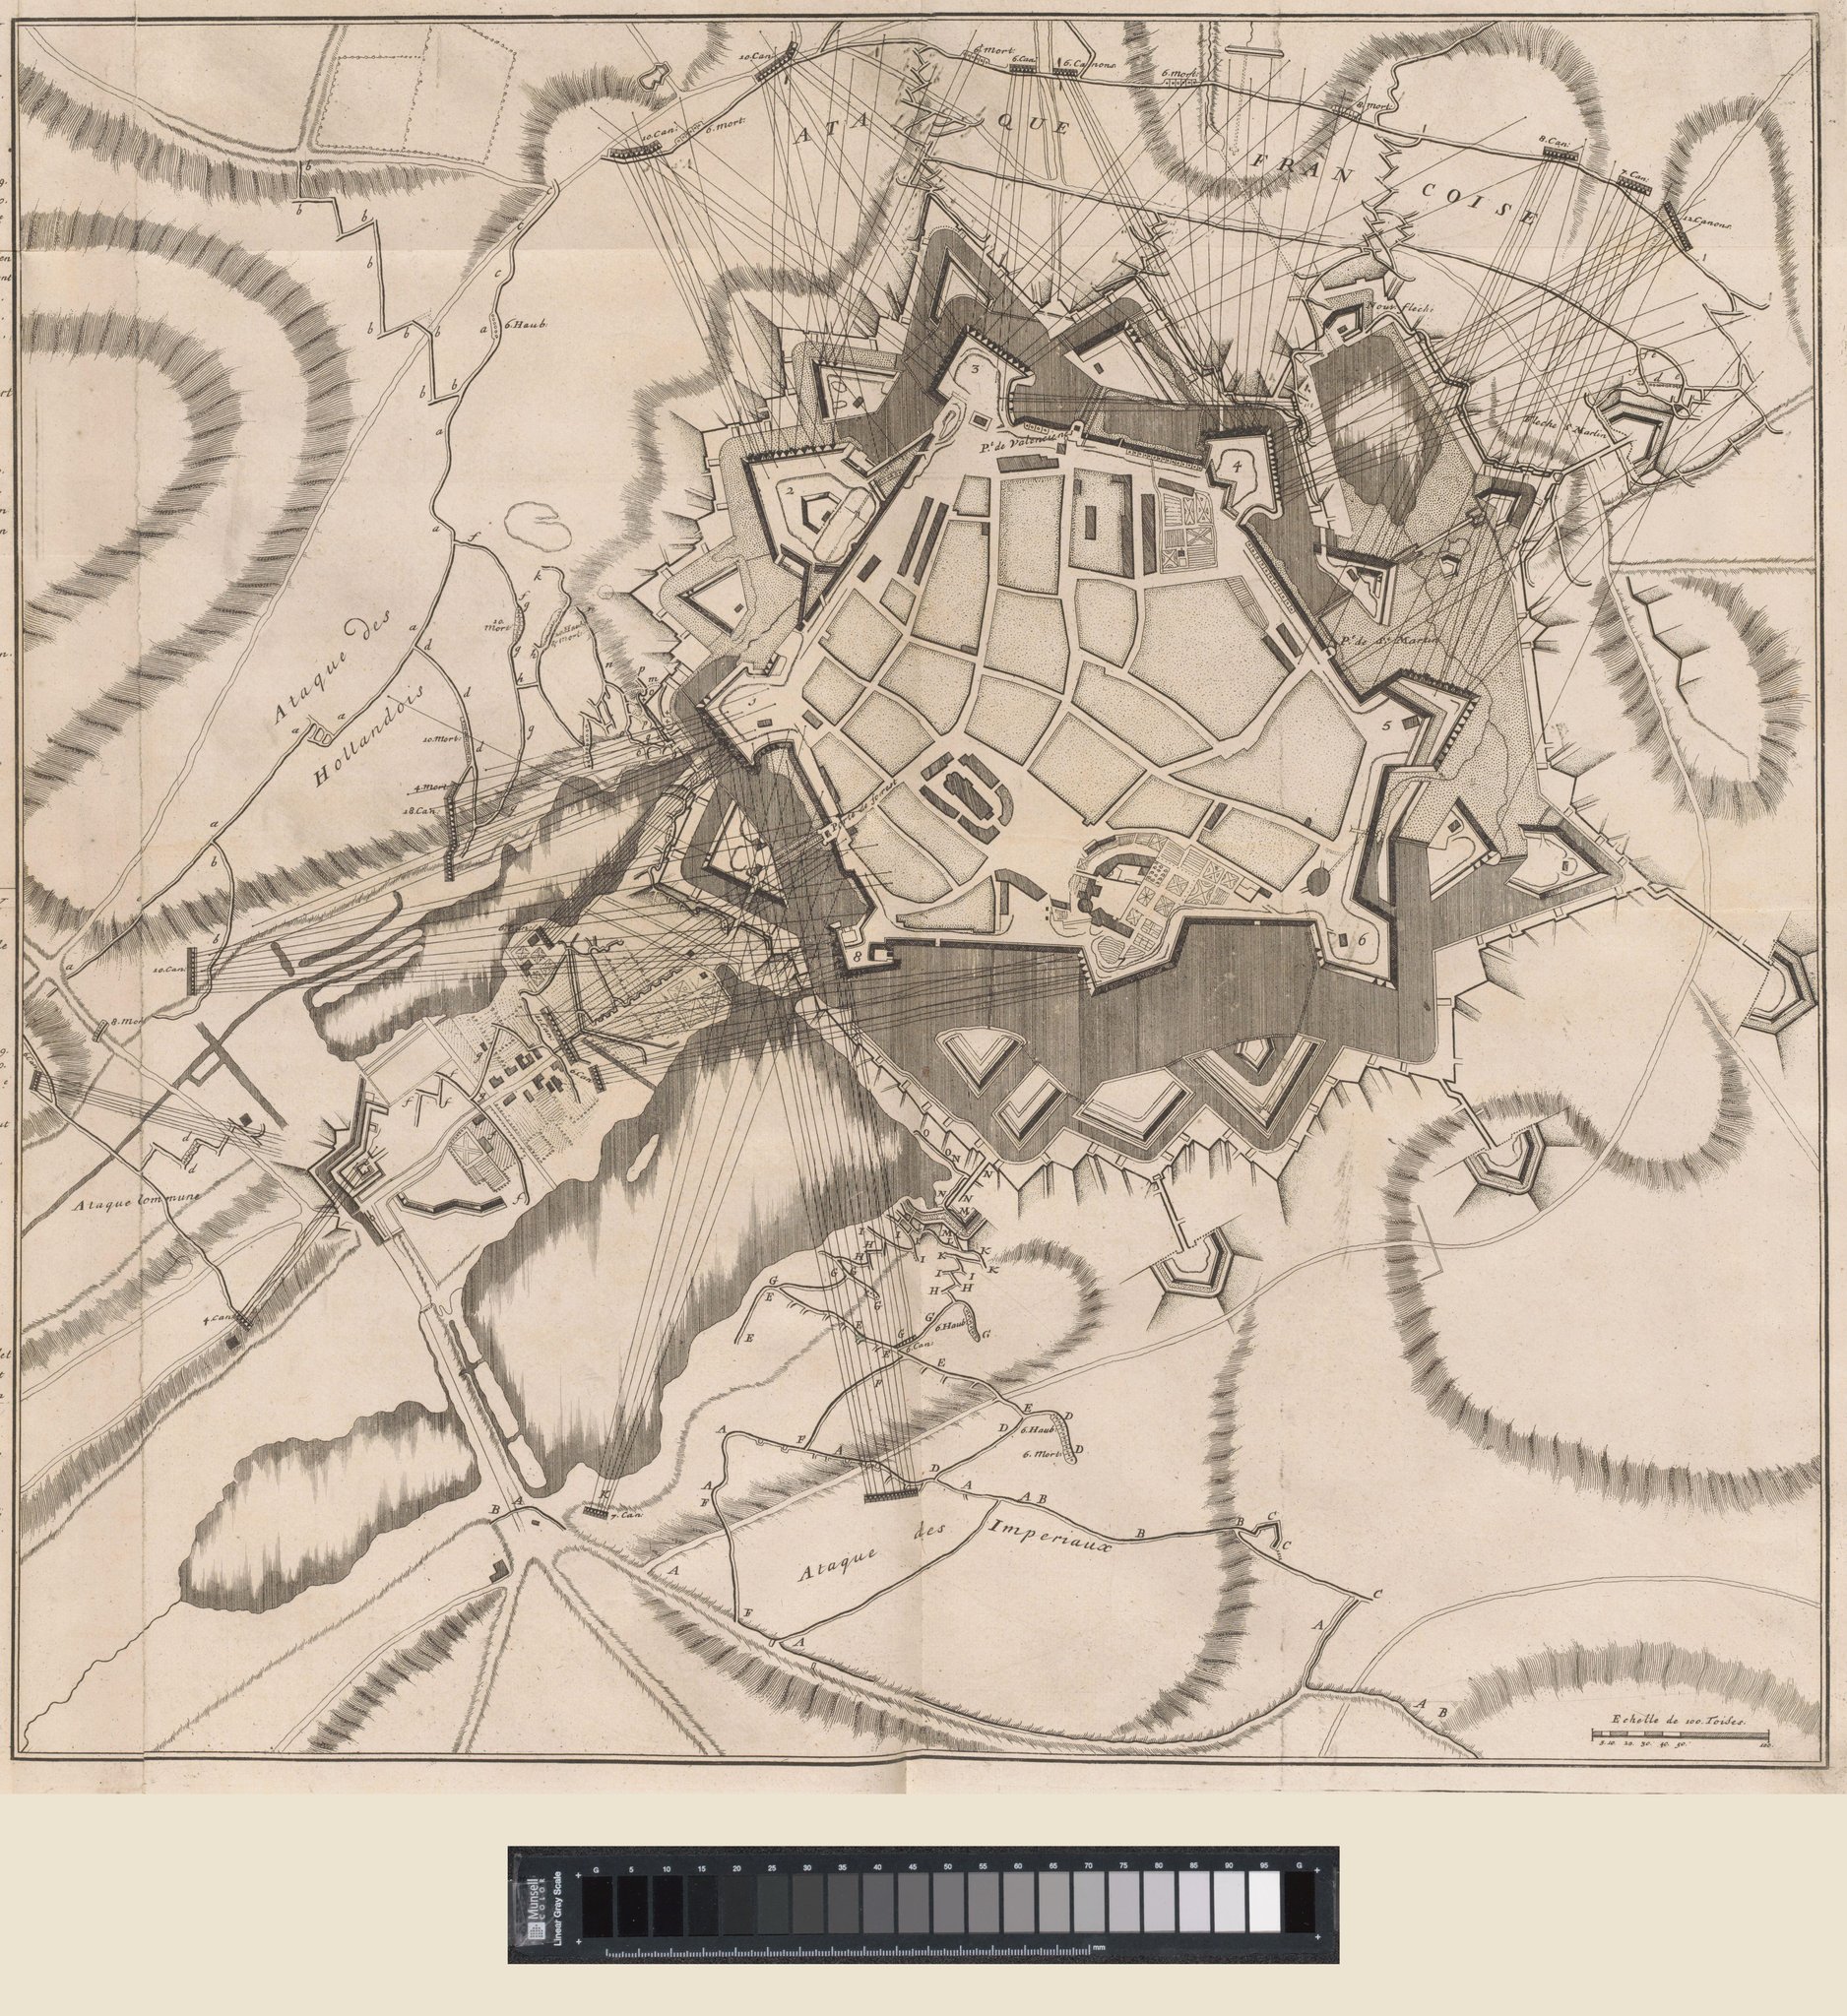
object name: map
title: Plan der Stadt van Quesnoy Ingesloten den 8. juni door den Generaal Baron Fagel (...) / Plan de la Ville de Quesnoy (...)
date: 1712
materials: paper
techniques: etching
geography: northern netherlands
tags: françois nicolaas fagel, john churchill (1e hertog van marlborough), siege, position war, maps of cities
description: Kaart van het beleg van le Quesnoy door de Geallieerden onder Baron Fagel vanaf 8 juni 1712. Ongenummerd. Illustratie in het tweede deel van : [Jean] du Mont, Oorlogskundige beschryving van de veldslagen en belegeringen, der drie ... wydvermaarde krygsoversten... den Prins Eugenius van Savoye, den ... Hertog van Marlborough, en den Prins van Oranje en Nassau-Vriesland, in de editie van 1729. Dit tweede deel is hoofdzakelijk gewijd aan de daden van de hertog van Marlborough en prins Johan Willem Friso.